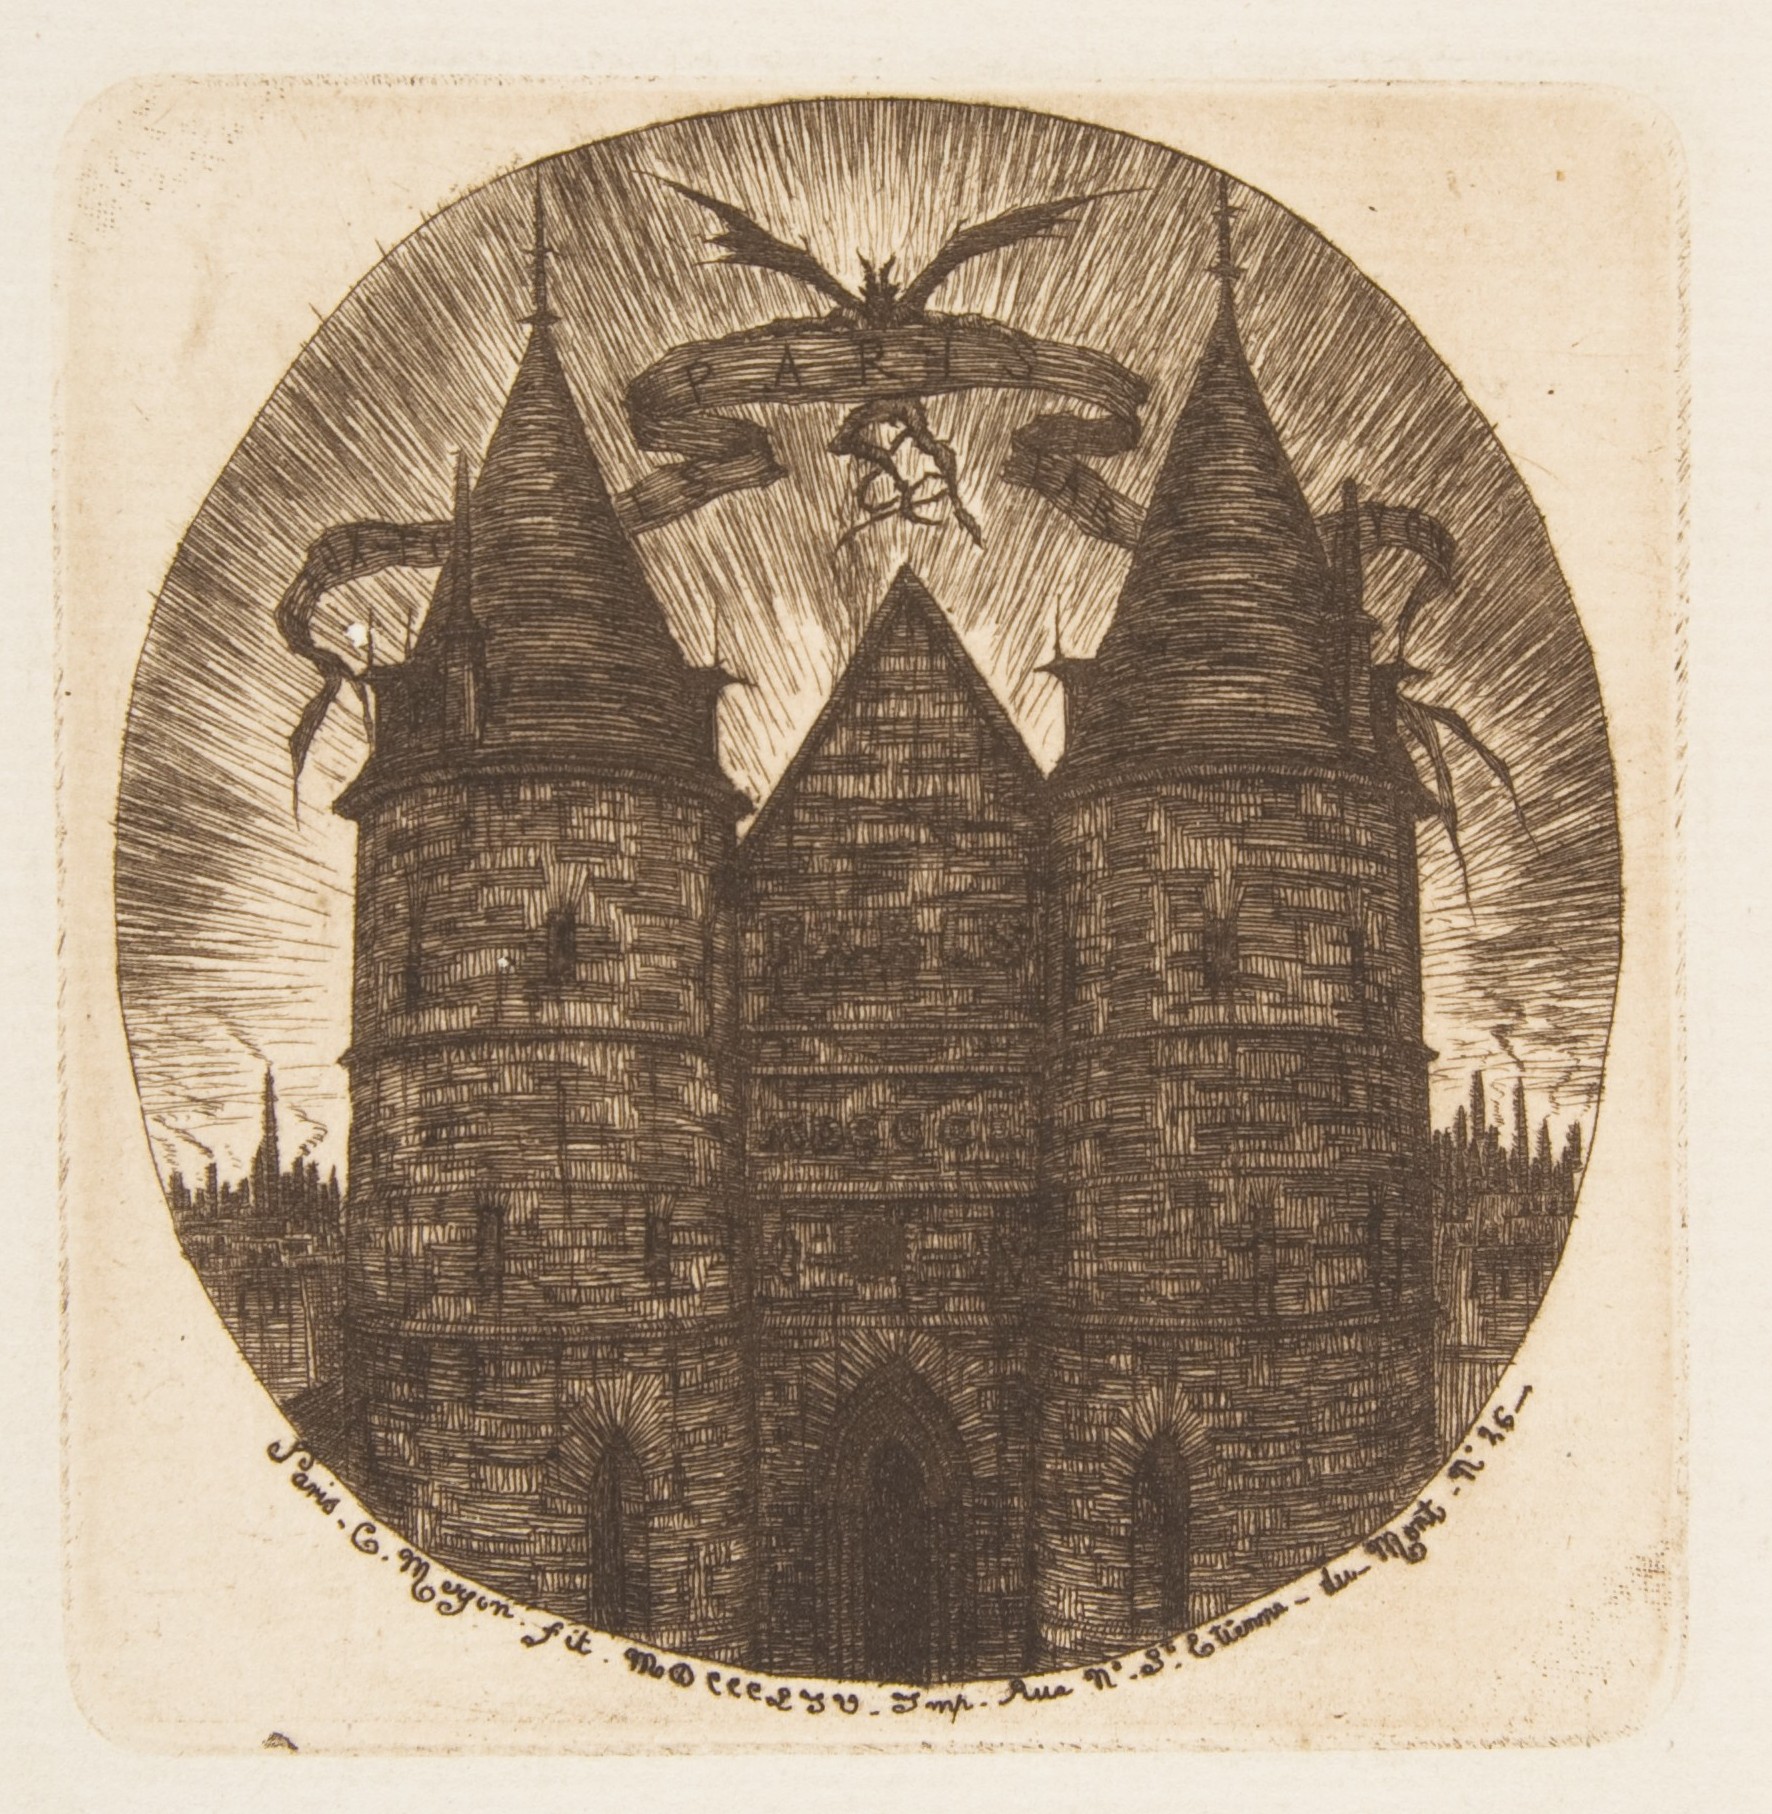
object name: print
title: The Old Entrance to the Palais de Justice, Paris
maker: charles meryon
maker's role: artist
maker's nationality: french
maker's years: 1821-1868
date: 1854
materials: ink, paper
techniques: drypoint, etching, printing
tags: palaces,paris